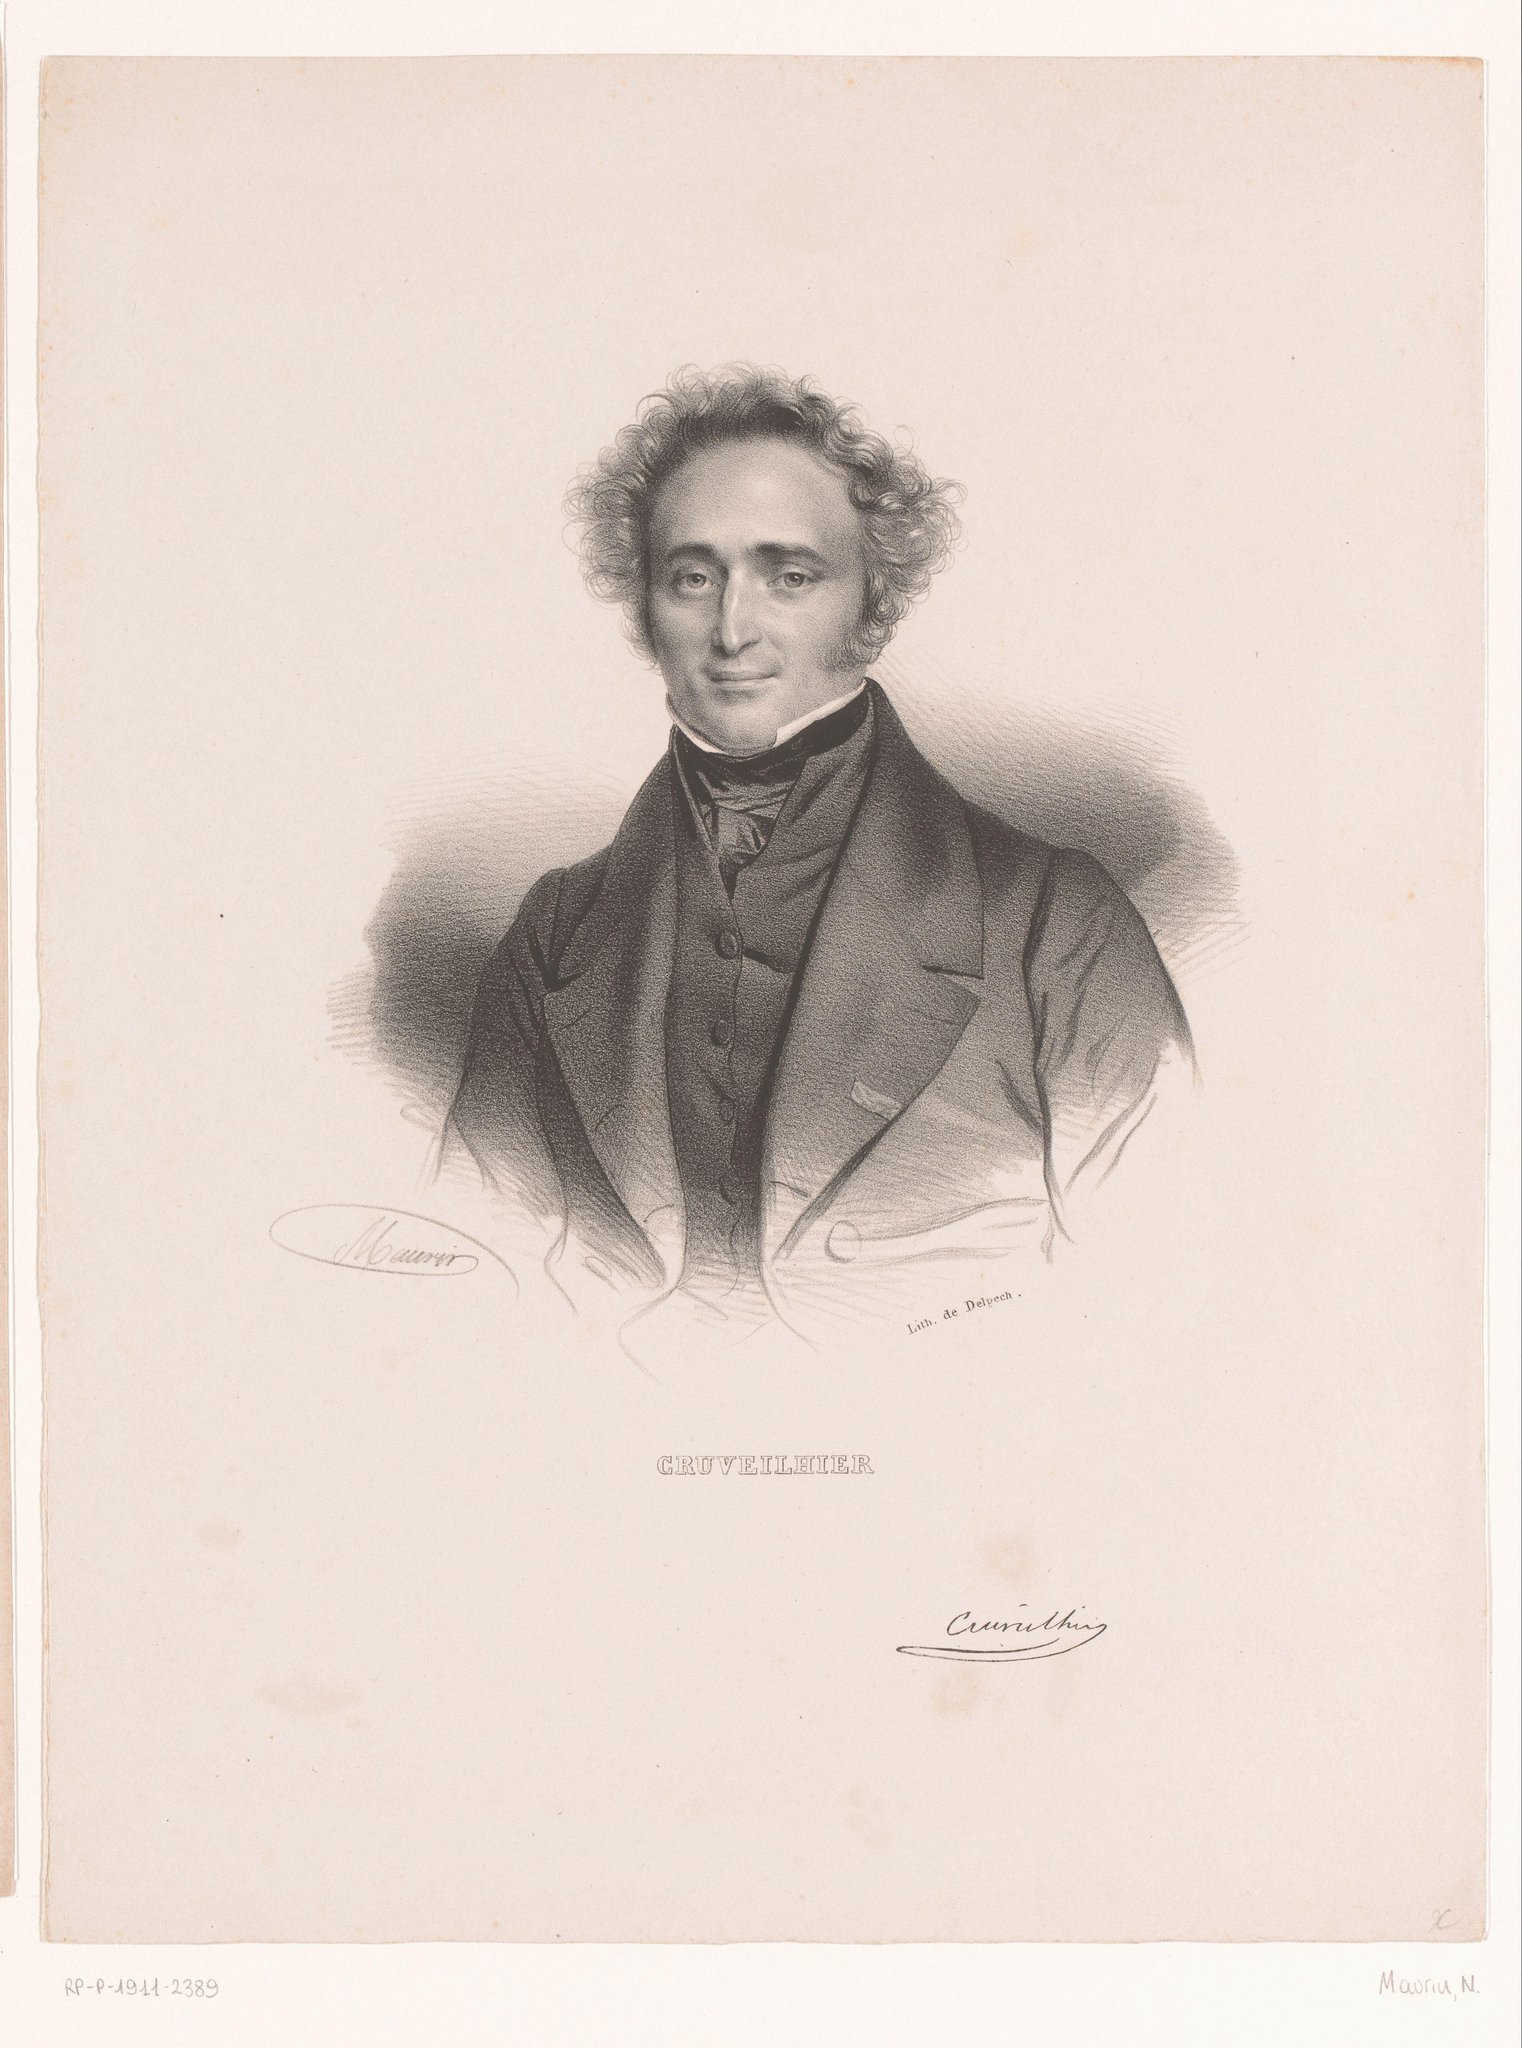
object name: print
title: Cruveilhier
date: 1838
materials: paper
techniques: lithograph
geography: paris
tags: historical persons, physician, doctor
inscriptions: collector's mark: Lugt 2228